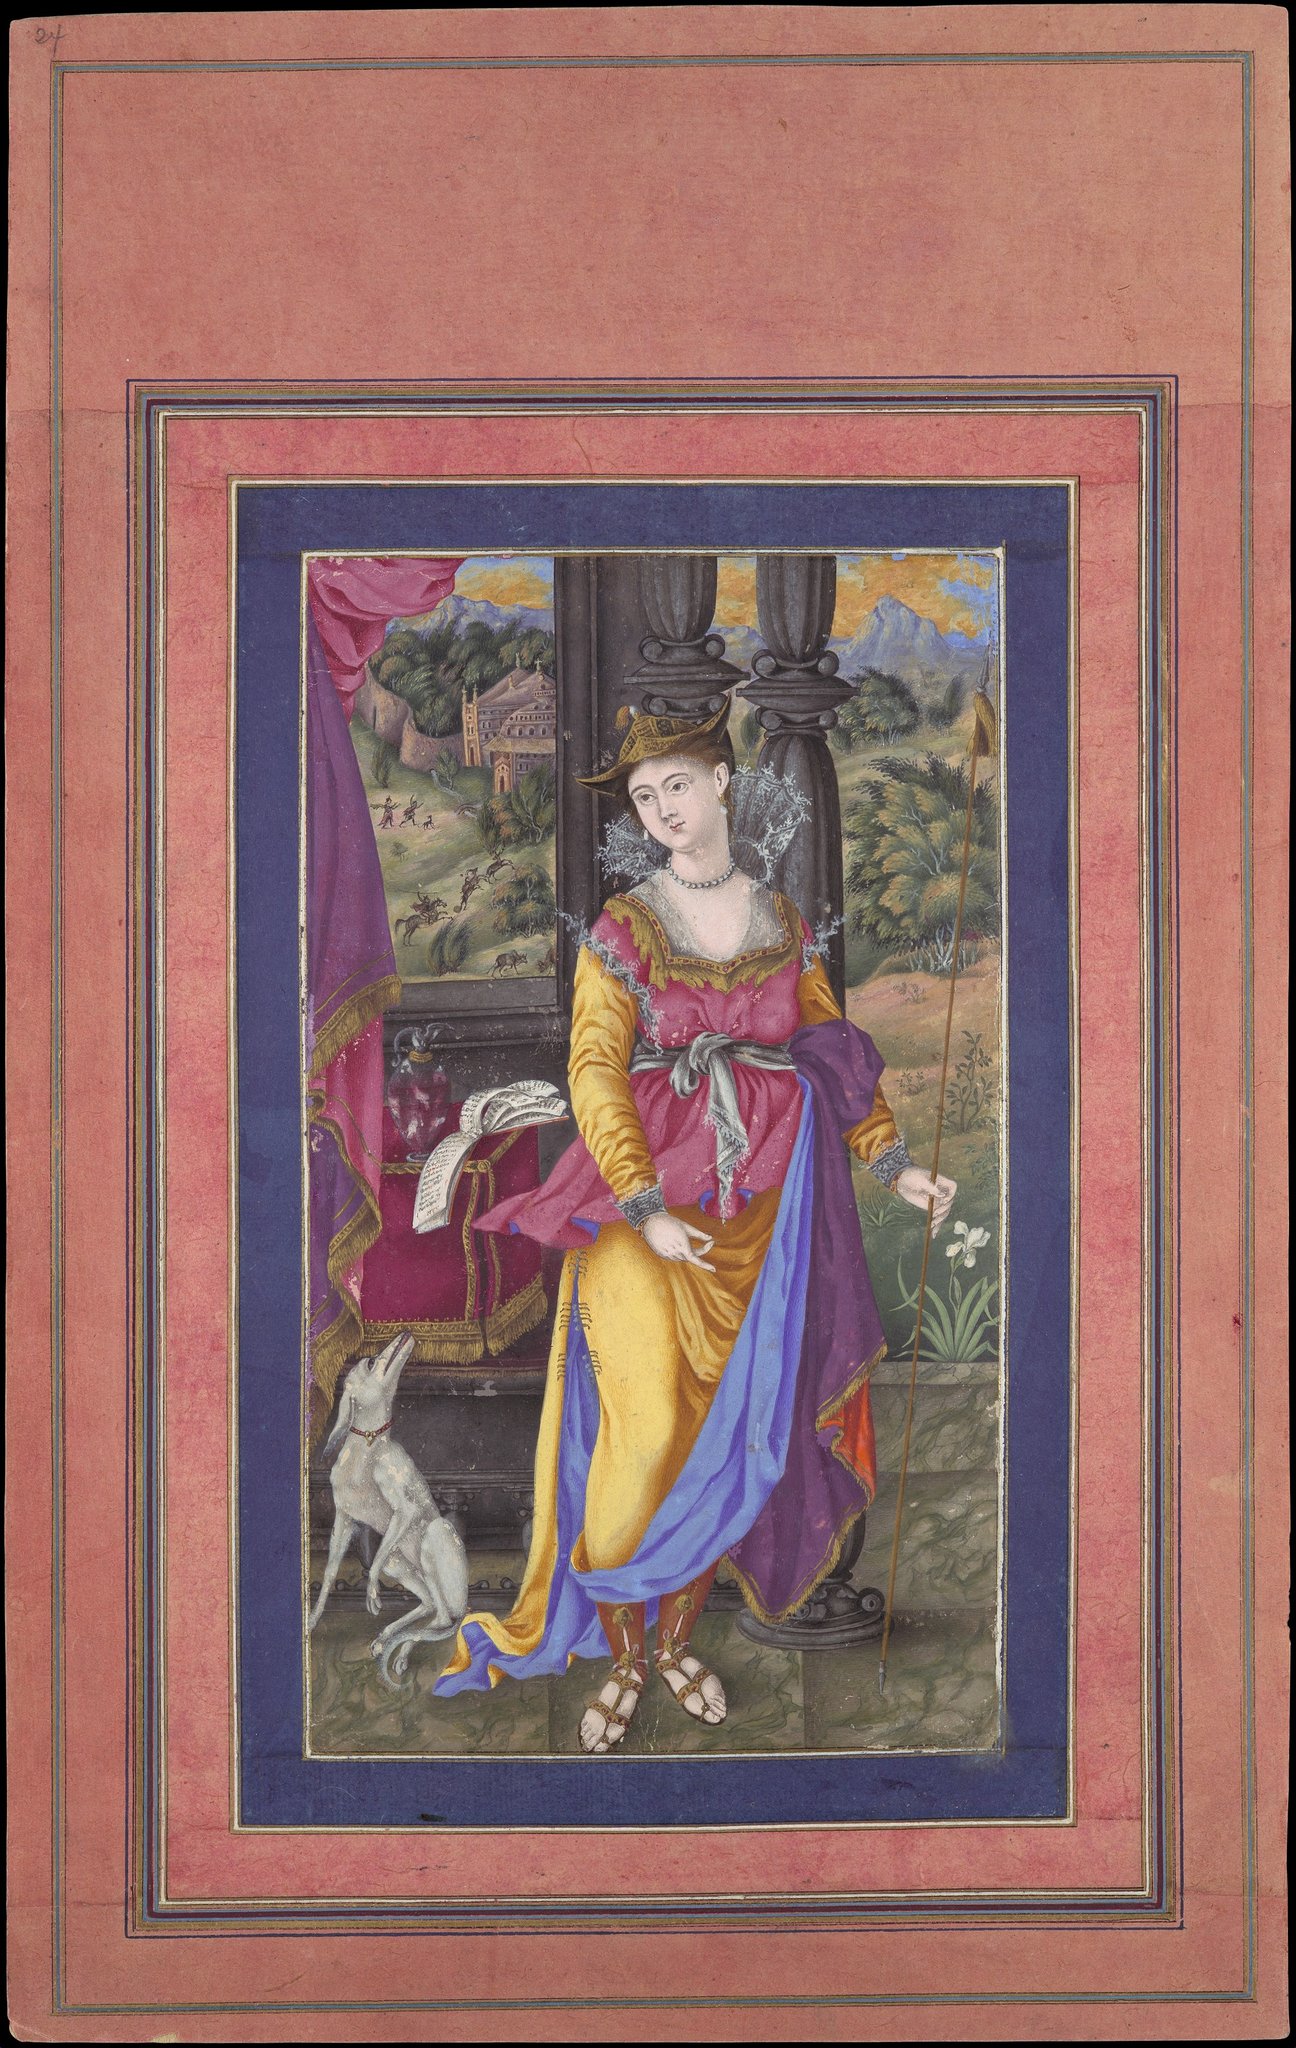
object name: illustrated album leaf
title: "Diana, Goddess of the Hunt", Folio from the Davis Album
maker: 'ali quli jabbadar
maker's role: artist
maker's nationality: iranian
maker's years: 1620-1699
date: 1601-1633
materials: gold, ink, paper, watercolor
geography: iran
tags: books,spears,hunting,diana,deer,dogs,curtains,pitchers